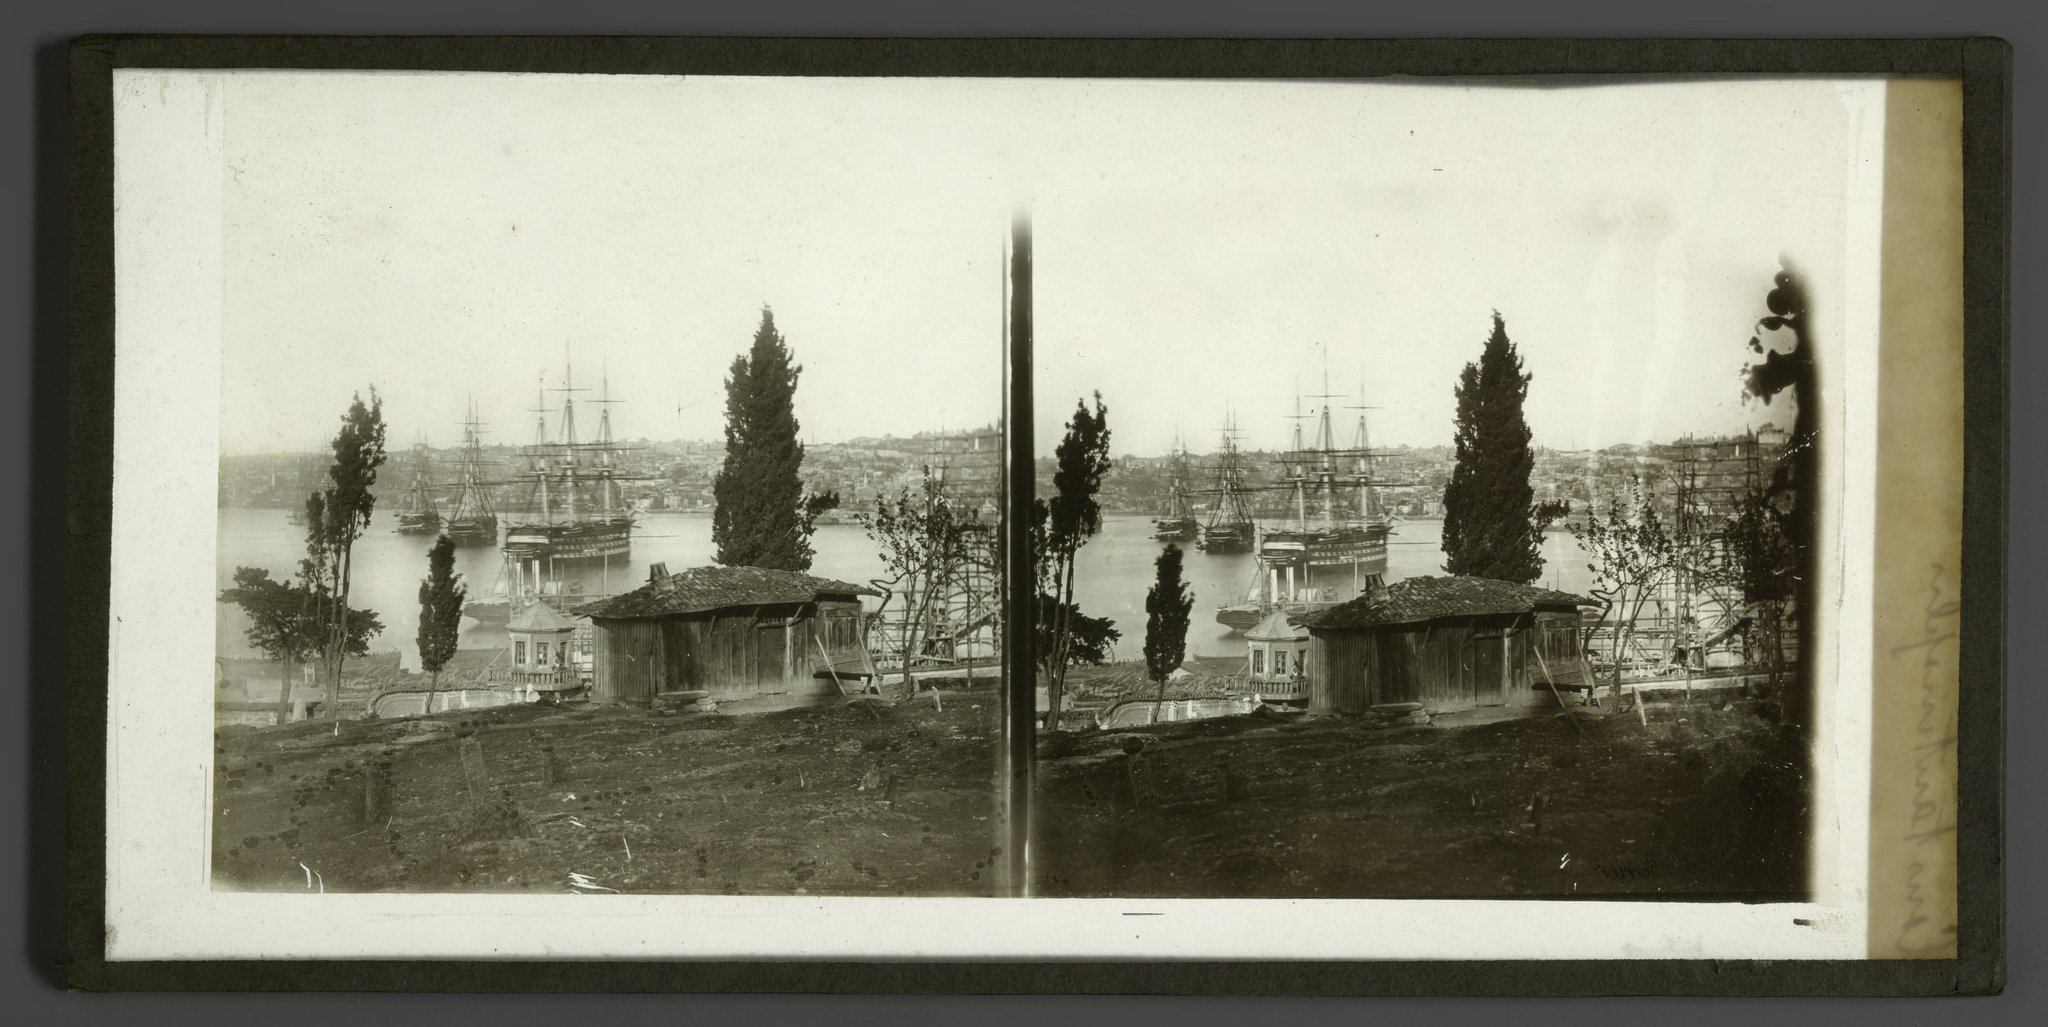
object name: stereoscopic photograph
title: Constantinople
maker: ferrier (fotograaf)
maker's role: fotograaf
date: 1860-1870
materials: glass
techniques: slide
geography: istanbul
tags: harbour